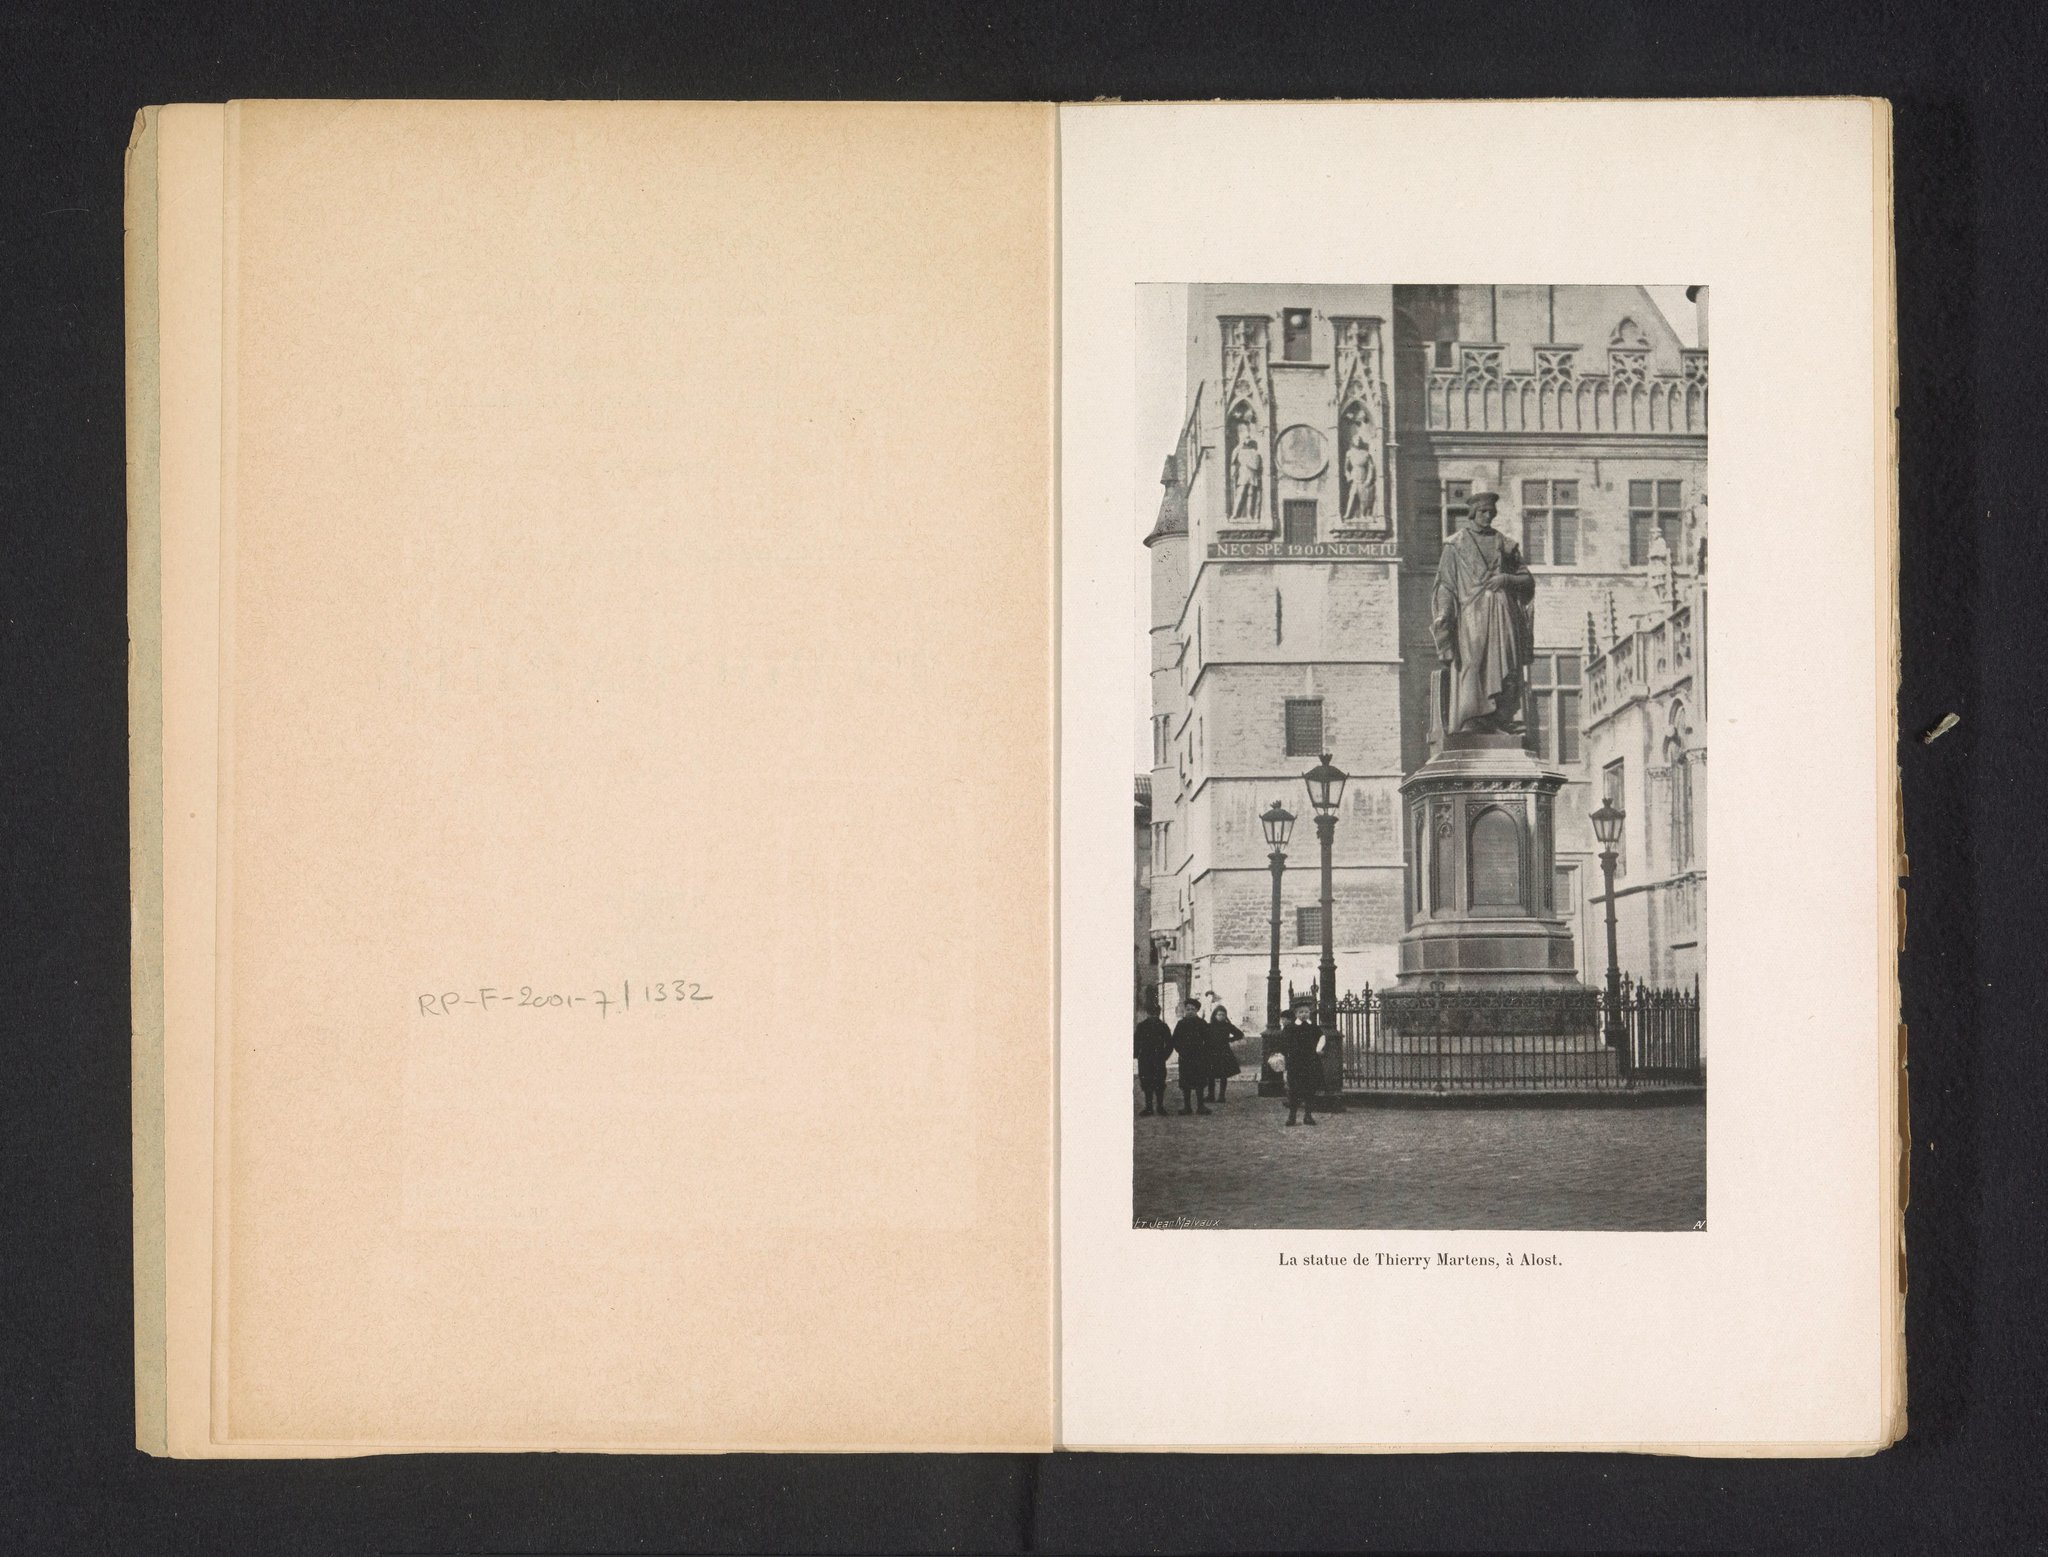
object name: photomechanical print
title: La statue de Thierry Martens, à Alost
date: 1906-1911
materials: paper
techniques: autotype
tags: printer, monument, statue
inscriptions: monogram: ‘AN’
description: Prent op tweede ongenummerde pagina na titelpagina.